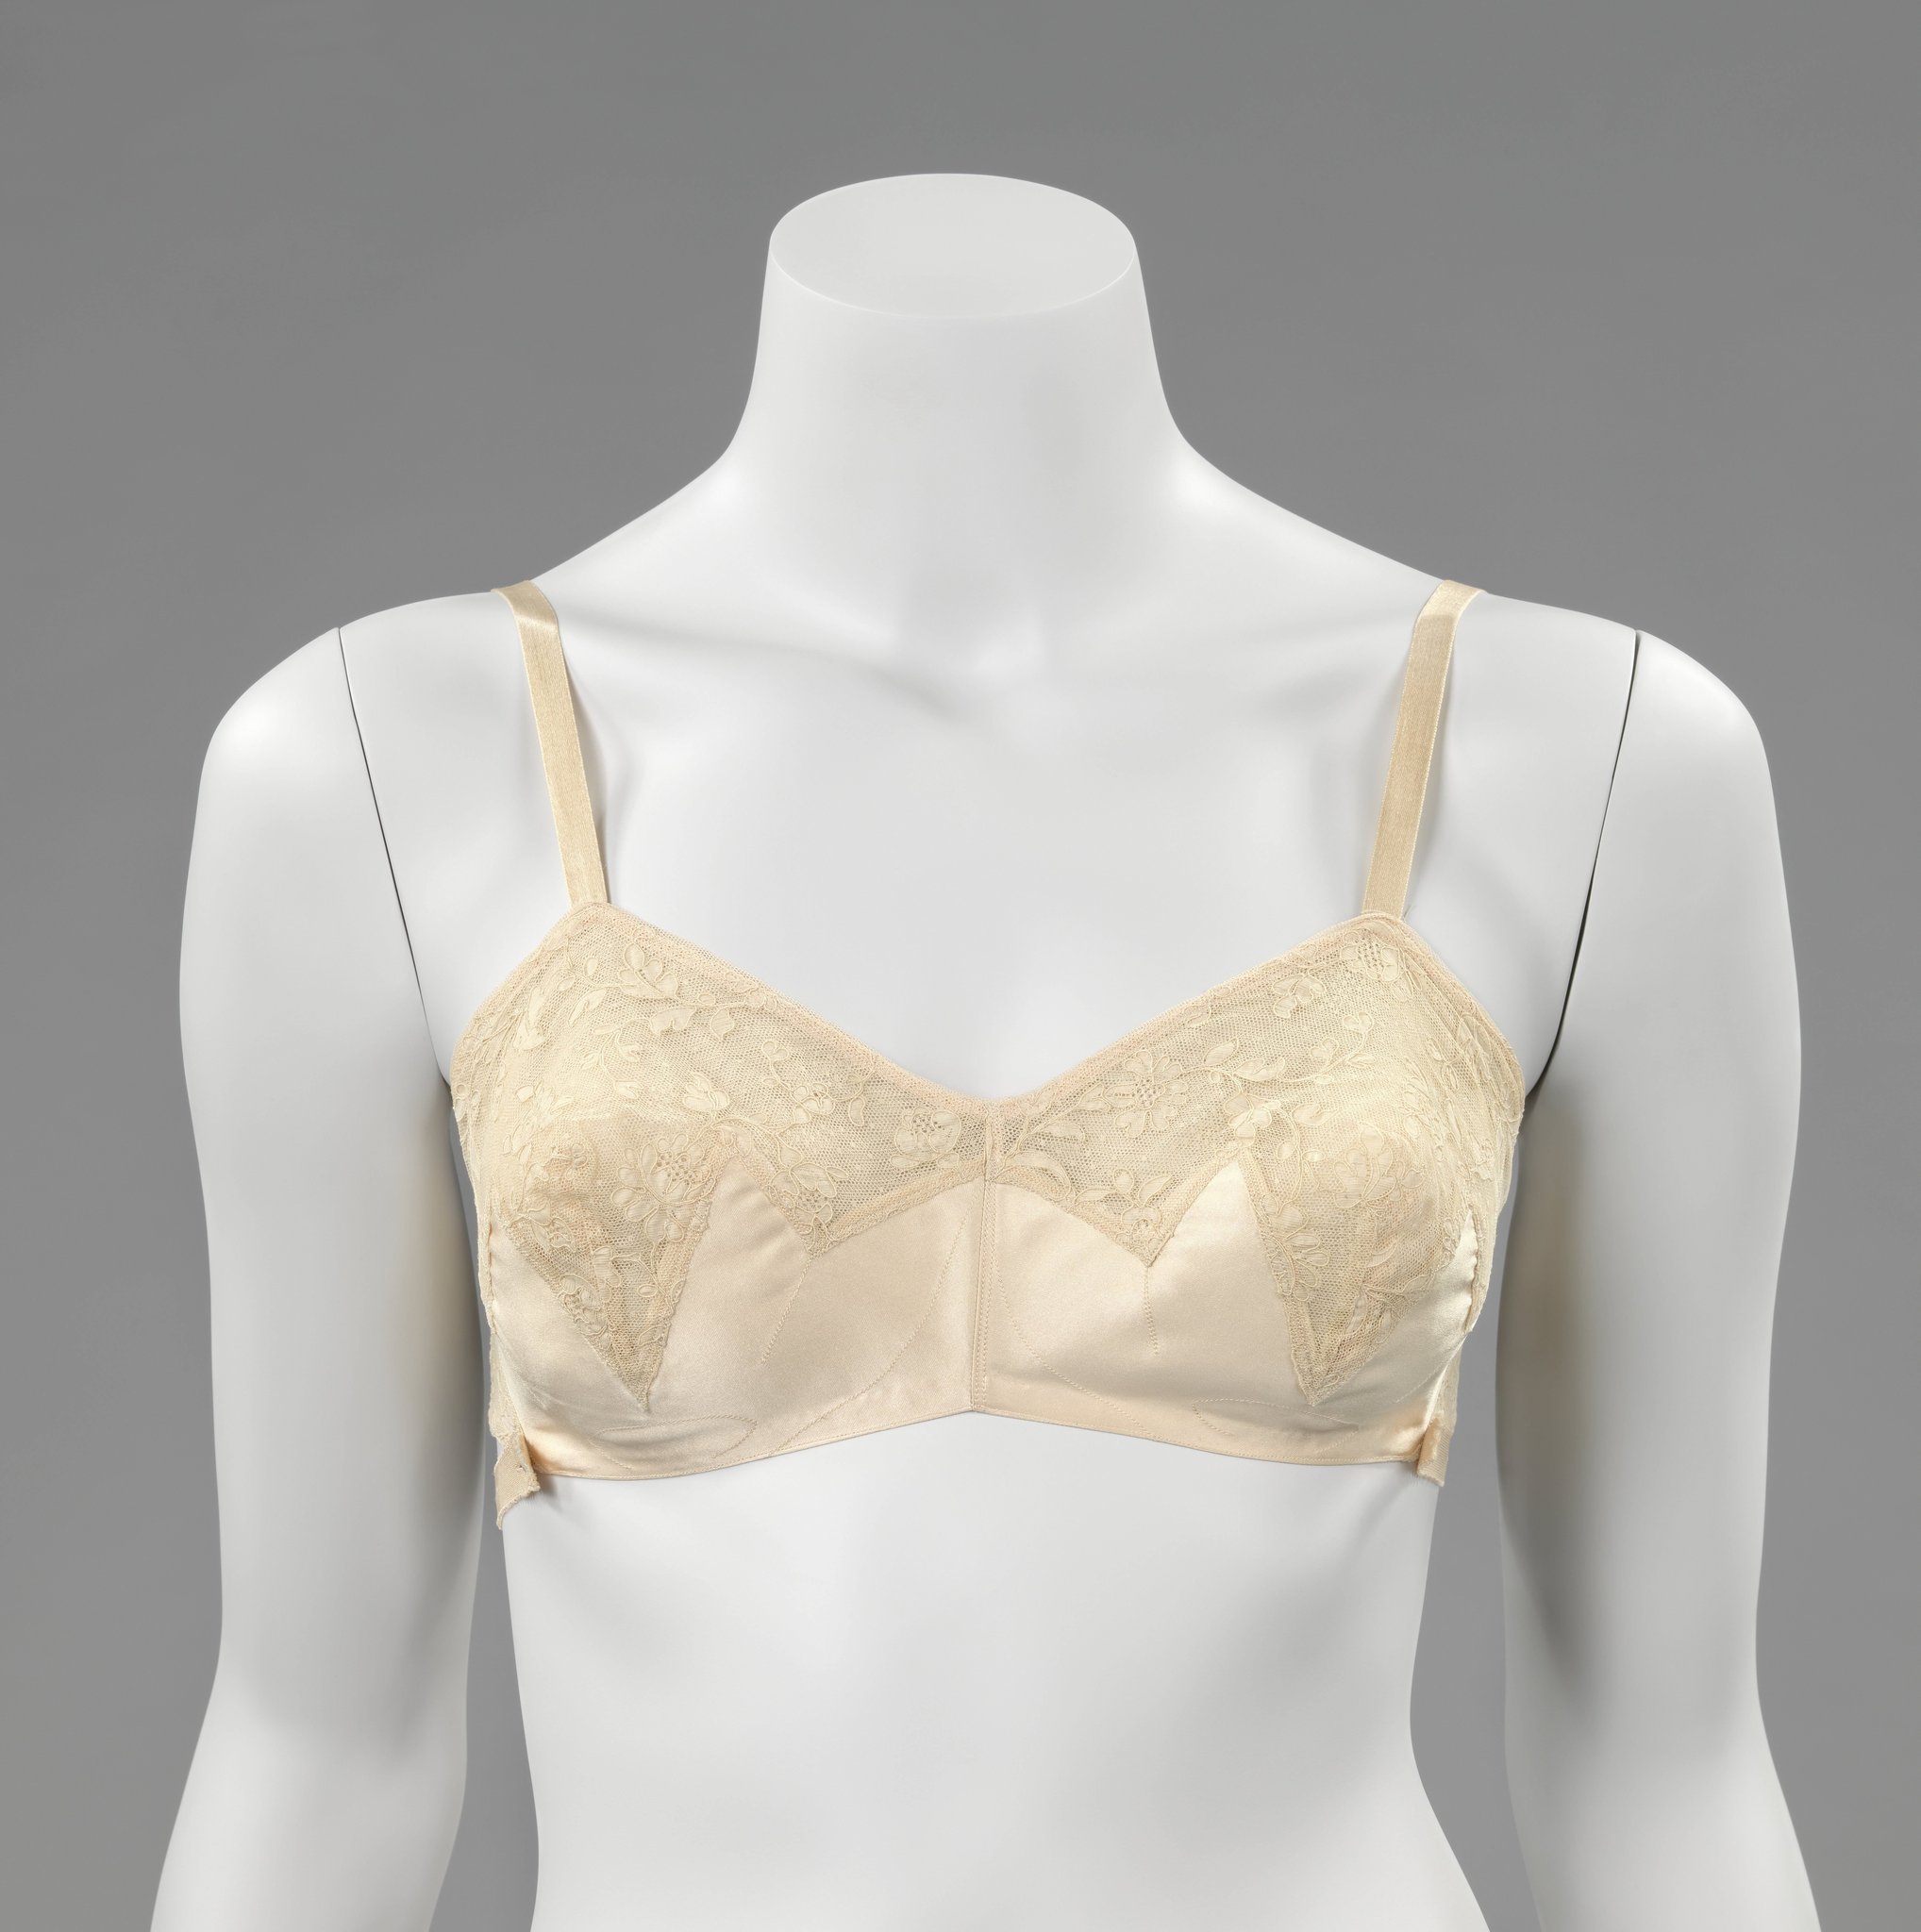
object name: lingerie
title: Bustehouder van zalmkleurig satijn met kant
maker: charmis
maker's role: modeontwerper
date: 1932-1940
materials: mother of pearl, silk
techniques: lace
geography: paris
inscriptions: address: ‘CHARMIS/Corsets-Deshabillés/ 7. Place de la Madeleine-Paris/ Made in France. Maison de Bonneterie/Amsterdam-Den Haag’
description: Bustehouder van zalmkleurig satijn met kant. Model: puntige cups, samengesteld uit zalmkleurig satijn voor de onderkant en kant aan de bovenkant. Smalle bandjes van satijnband met aan de uiteinden op de rug een klein stukje elastiek. Sluiting aan de zijkanten door middel van twee, op de rug gekruiste, smalle elastieke banden met knoopsgaten en twee kleine parelmoeren knoopjes aan de buitenkant van de borsten. Het kant is gevoerd met zalmkleurige tule; het satijn met satijn. Ondersteunende kleding.